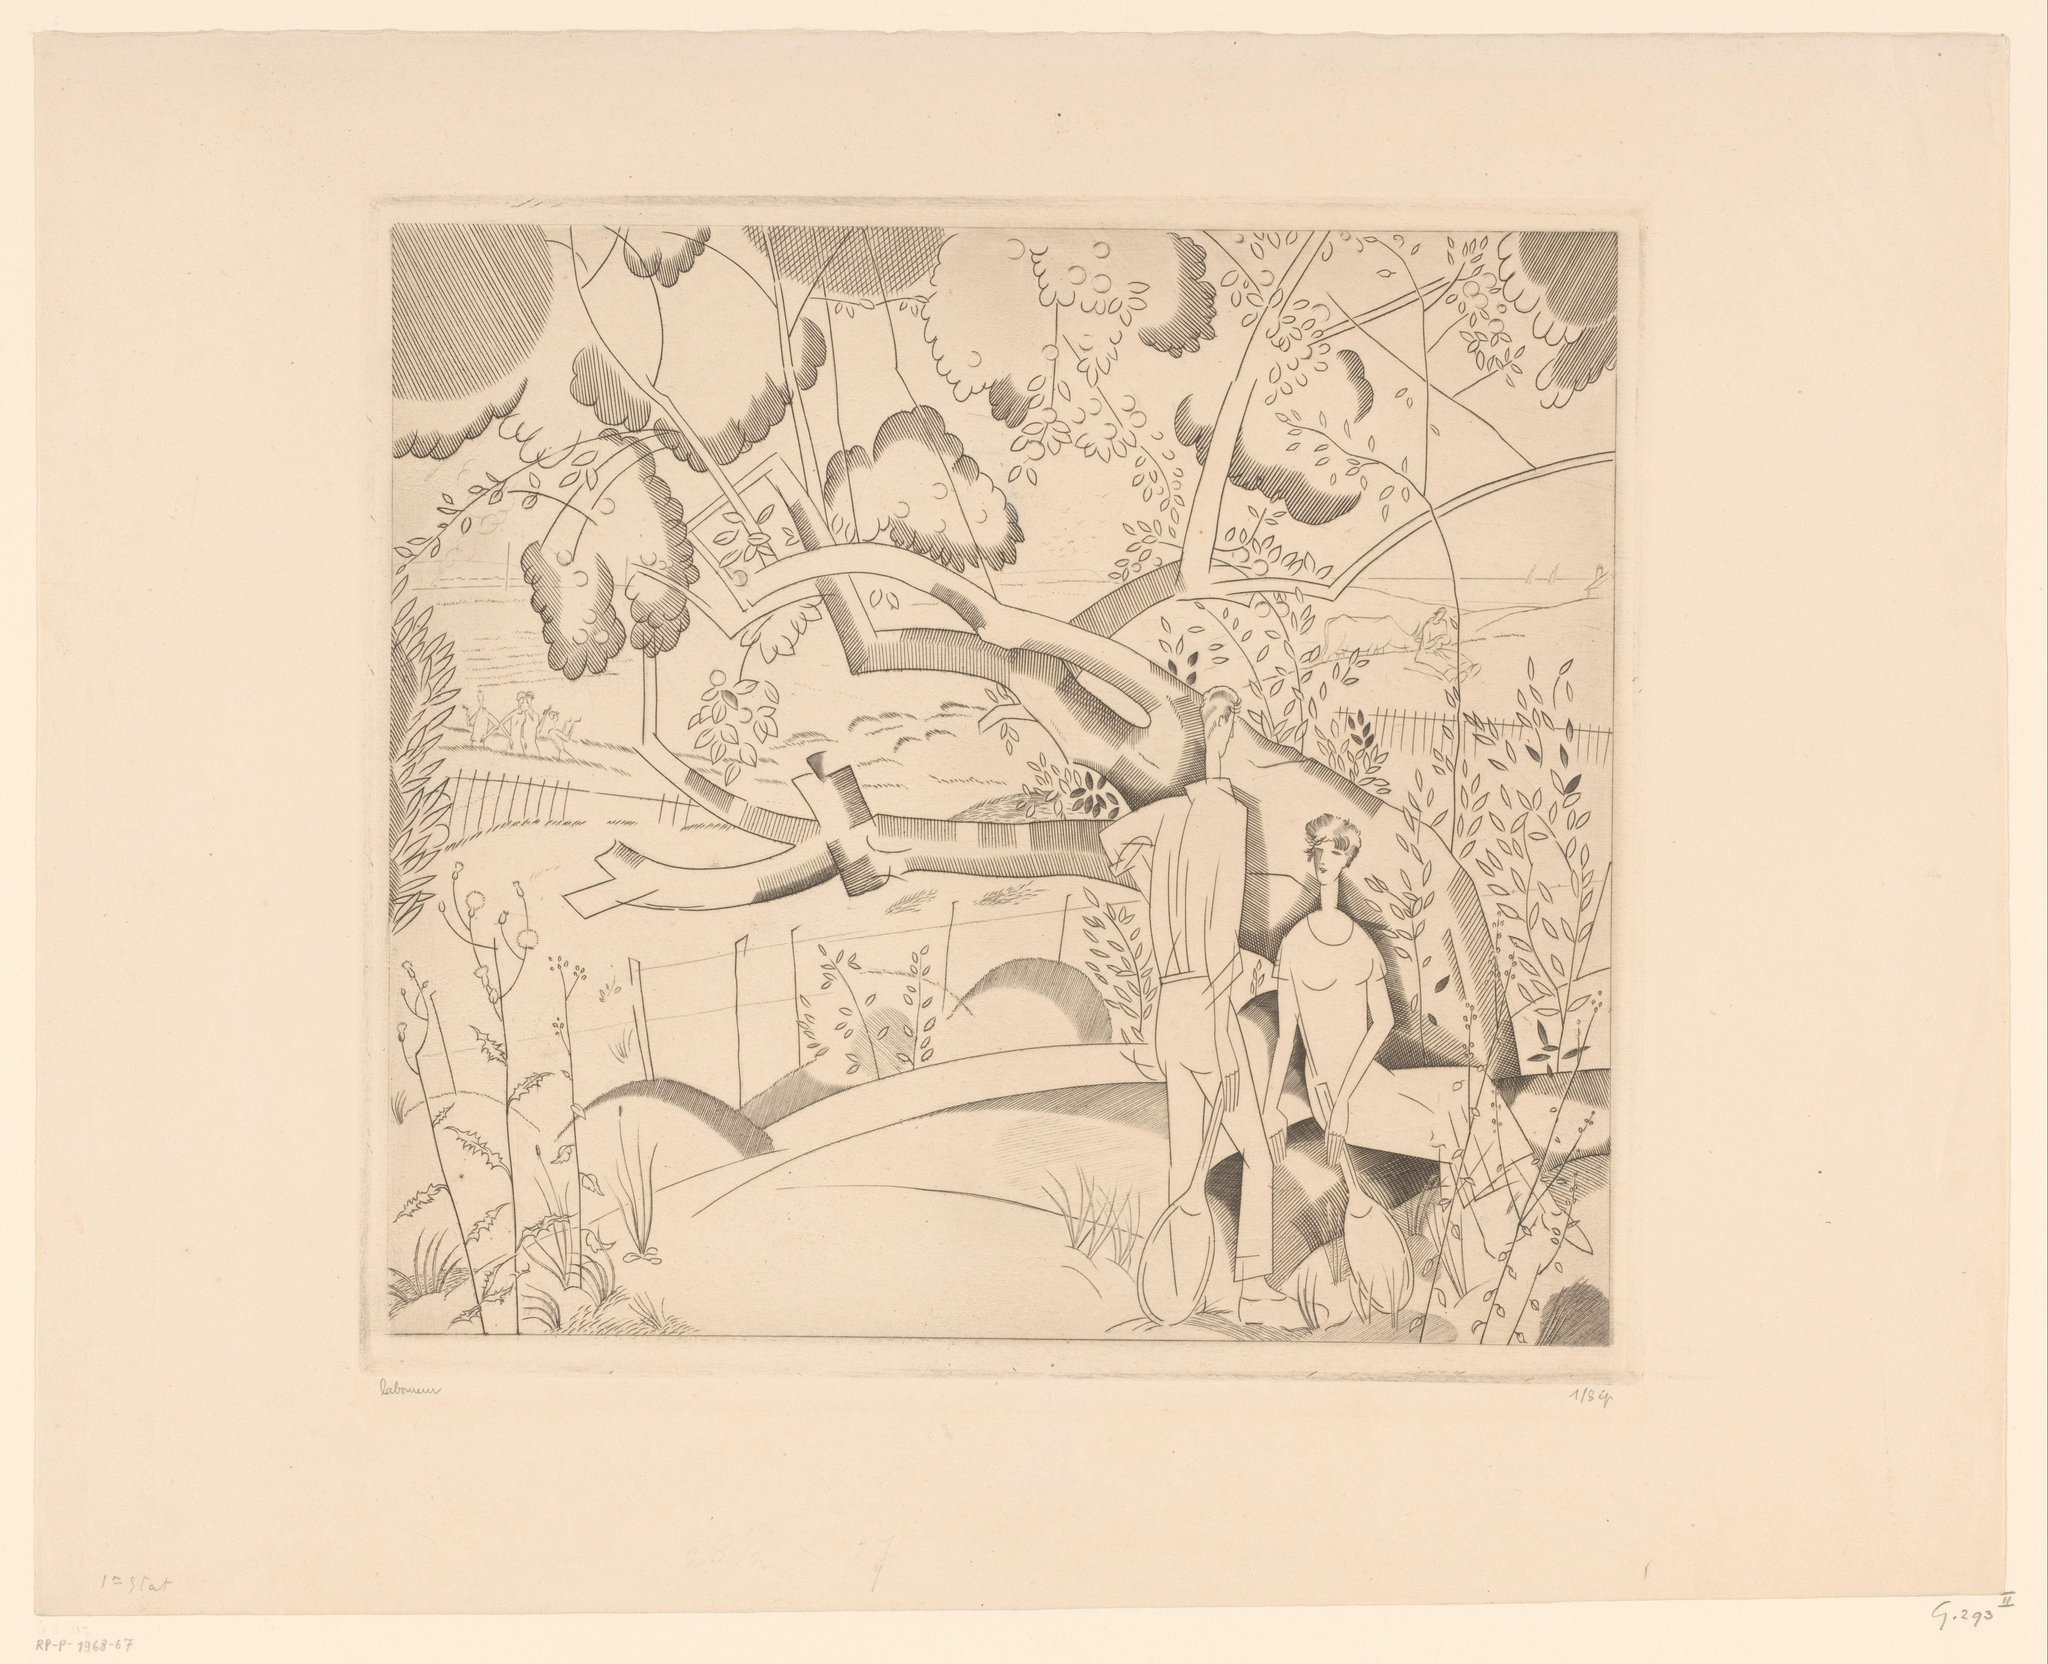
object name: print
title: Rustende tennisspelers bij perenboom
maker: jean emile laboureur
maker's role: draughtsman, print maker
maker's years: 1877-1943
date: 1925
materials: paper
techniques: engraving, intaglio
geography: france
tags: tennis, lawn-tennis, 25g3(pear-tree)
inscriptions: collector's mark: Lugt 2760, collector's mark: Lugt 2228, watermark